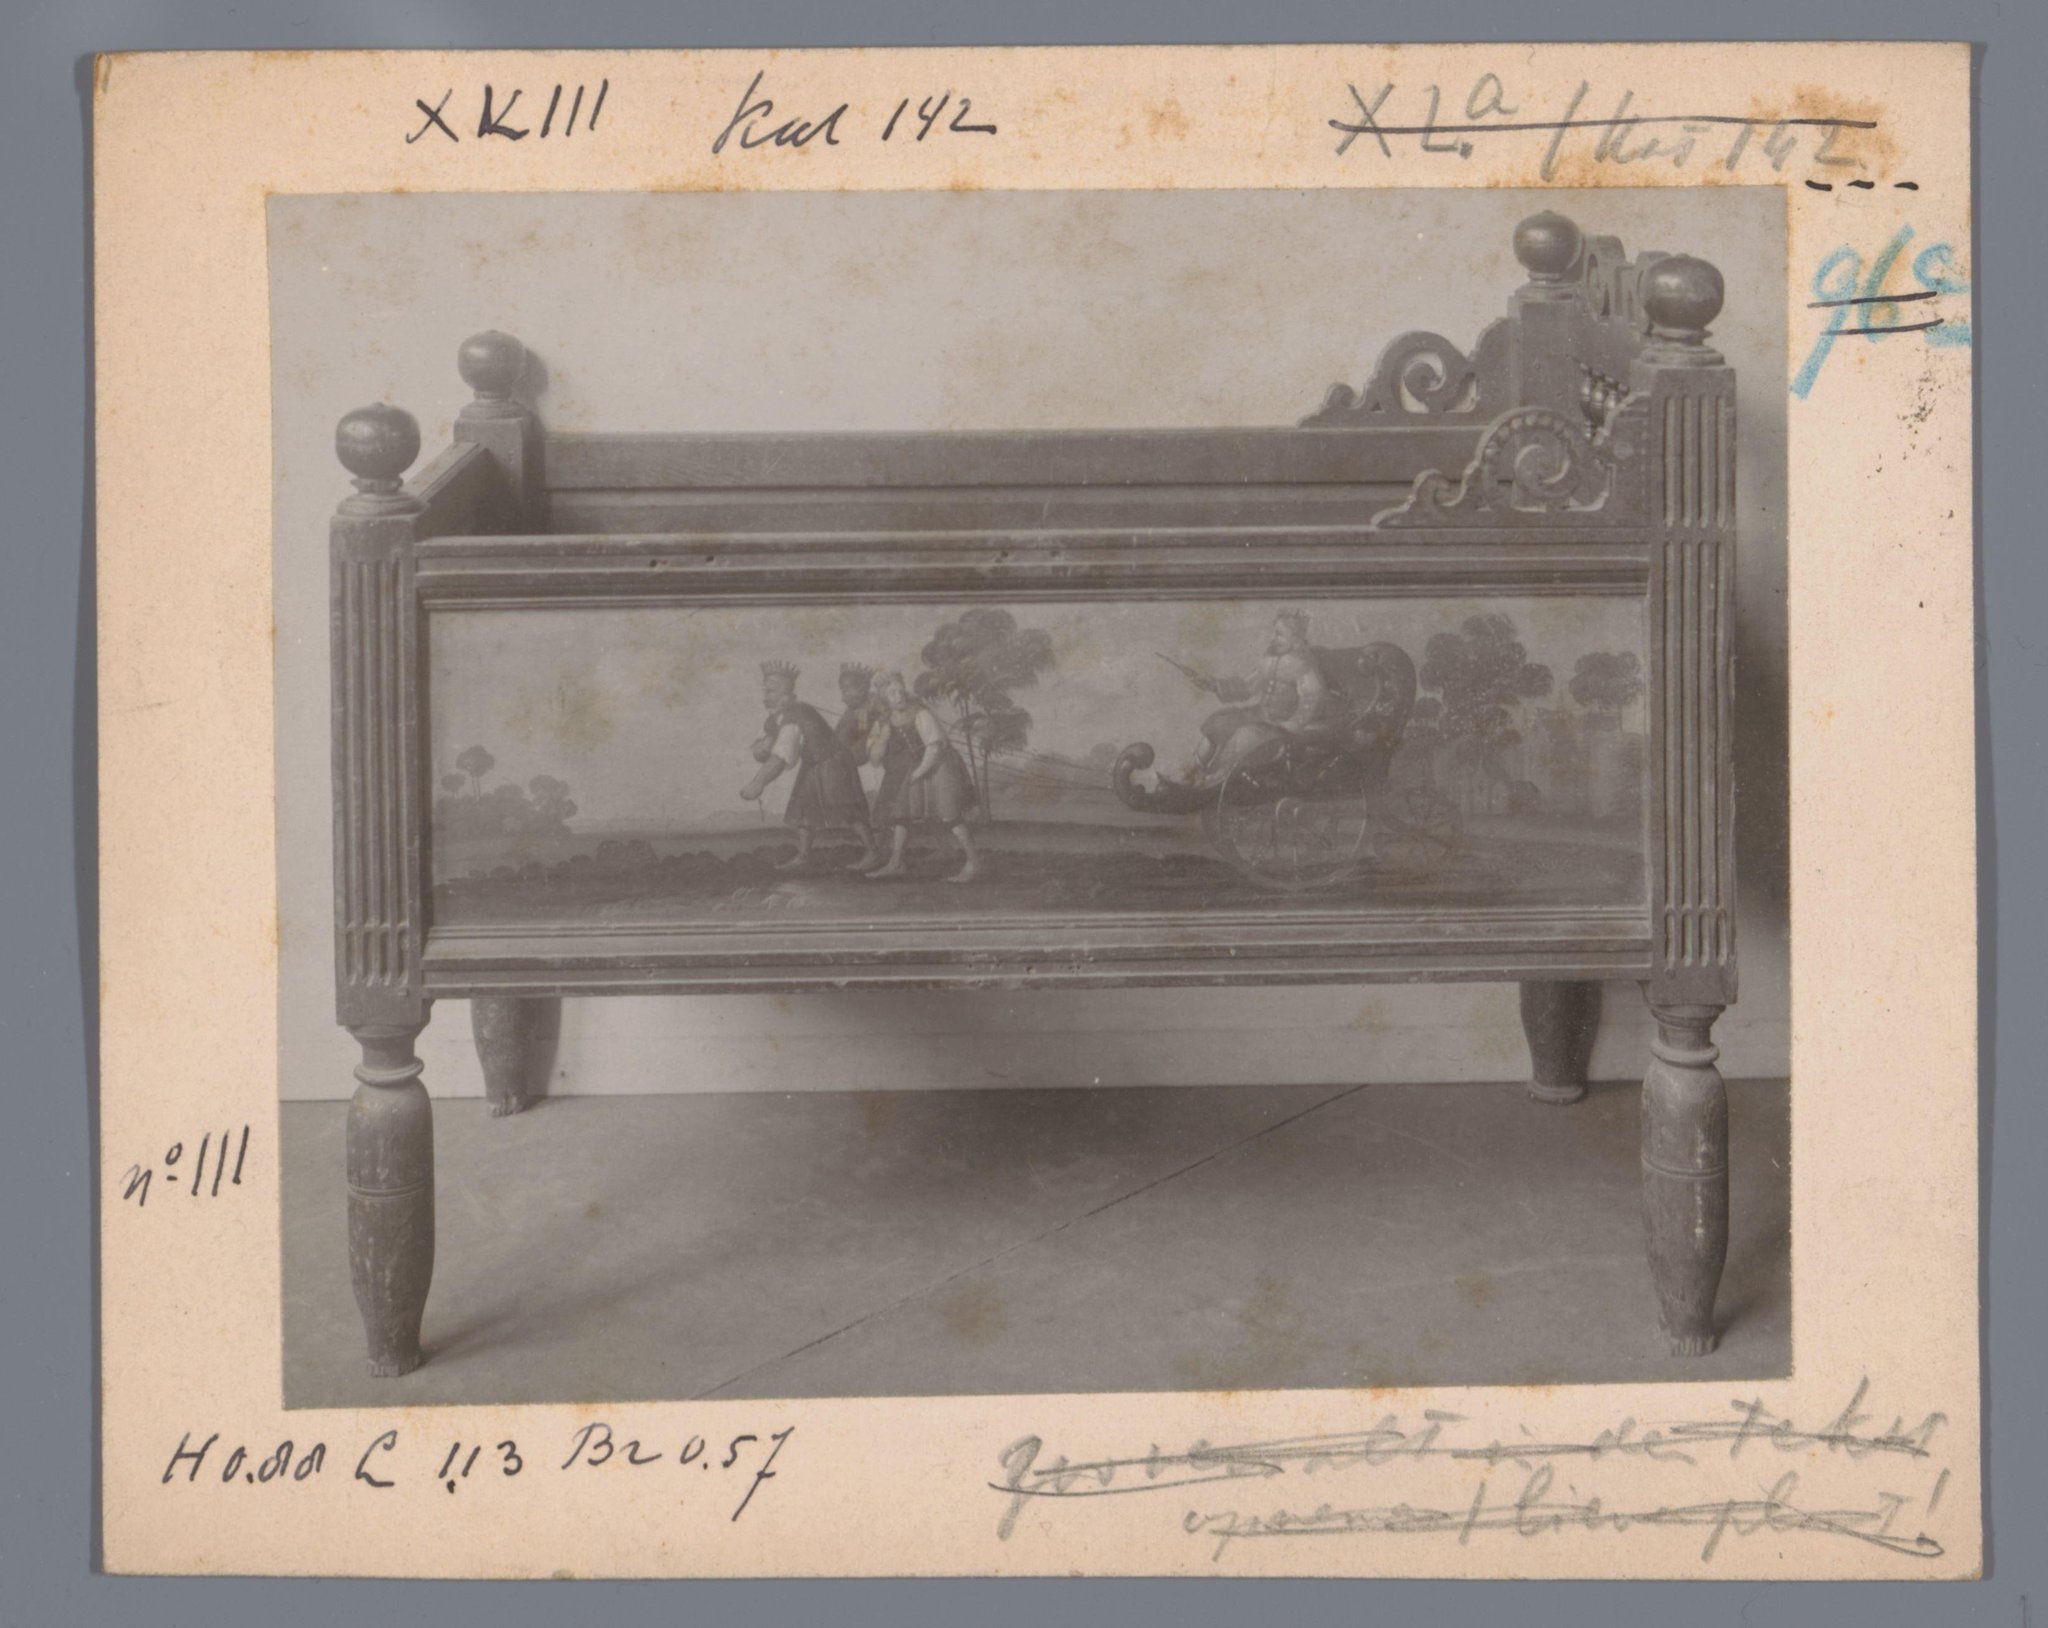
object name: photograph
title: Kinderledikant beschilderd met een koning in triomfwagen in het Rijksmuseum te Amsterdam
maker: Anonymous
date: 1875-1900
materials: photographic support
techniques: matte daylight collodion silver print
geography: amsterdam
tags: bed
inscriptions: number: ‘XLIII kat 142 no. 111’, collector's mark: ‘Kunstnijverheidschool Quellinus Amsterdam Frans Halsstraat 14.’, collector's mark: ‘Instituut voor kunst-nijverheidsonderwijs Gabriël Metsustraat No. 16, Amsterdam’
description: Zie voor het originele object BK-NM-8266.